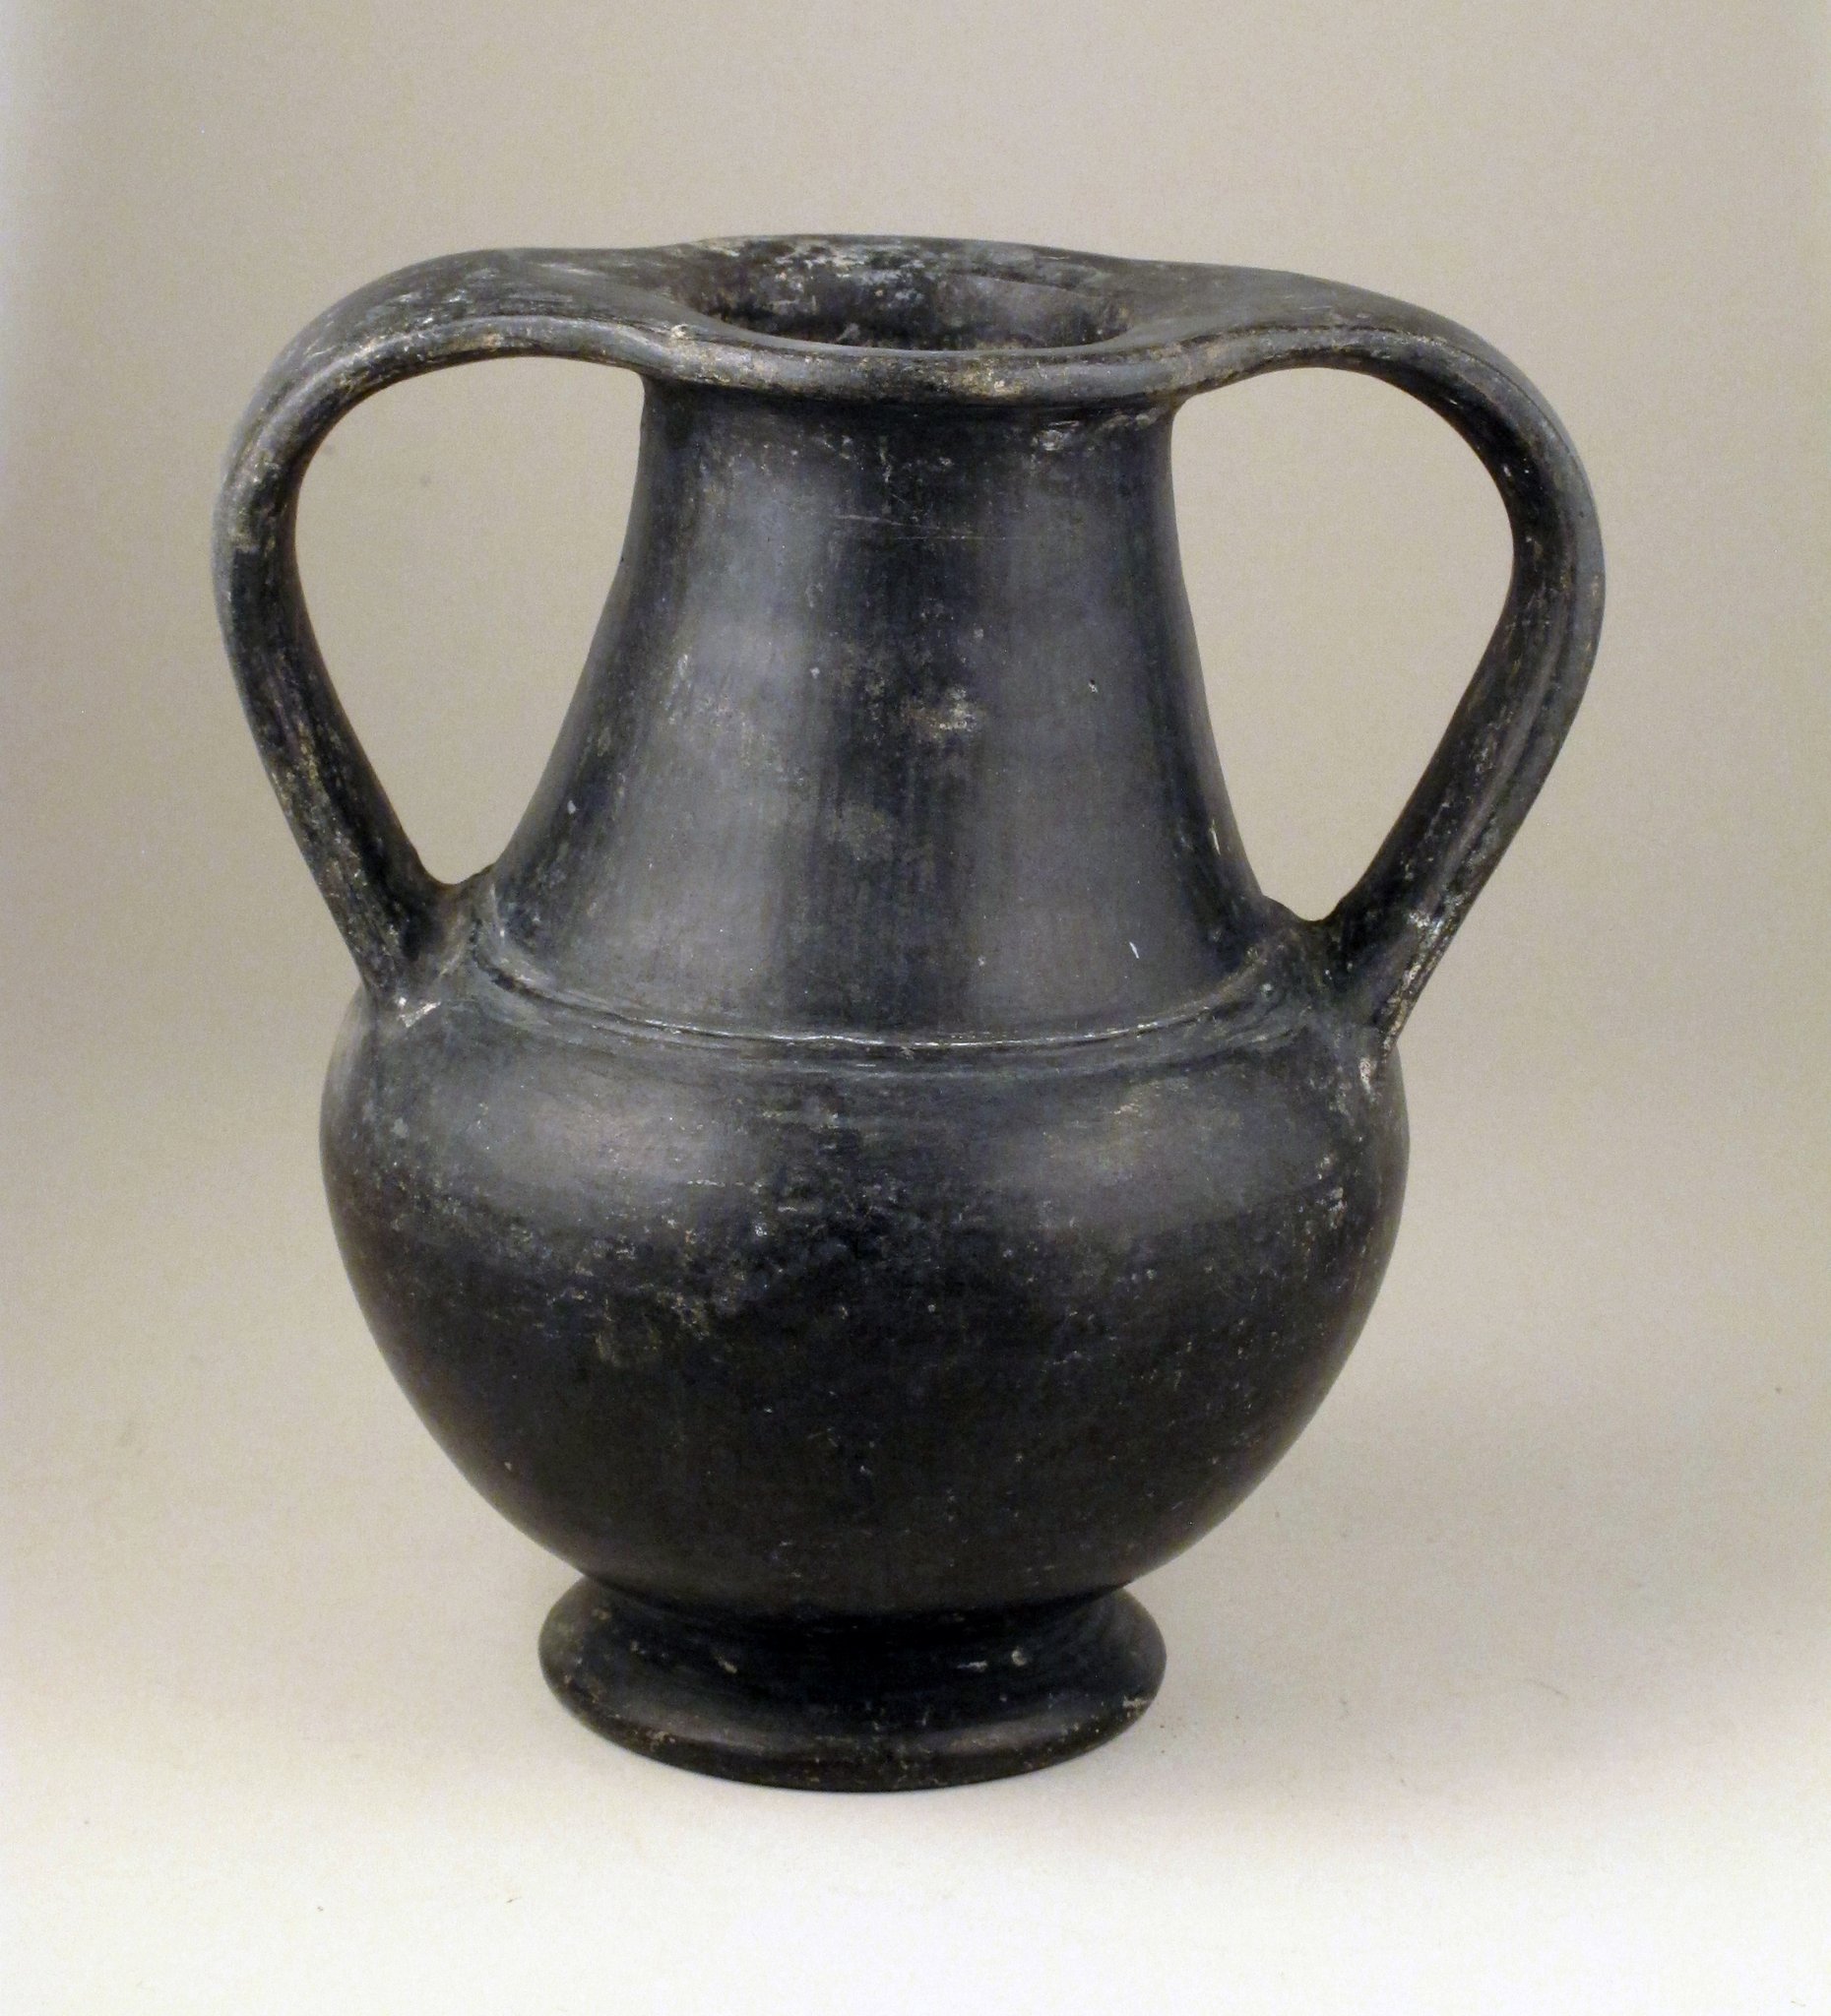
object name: amphora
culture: etruscan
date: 560-520 BCE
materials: terracotta